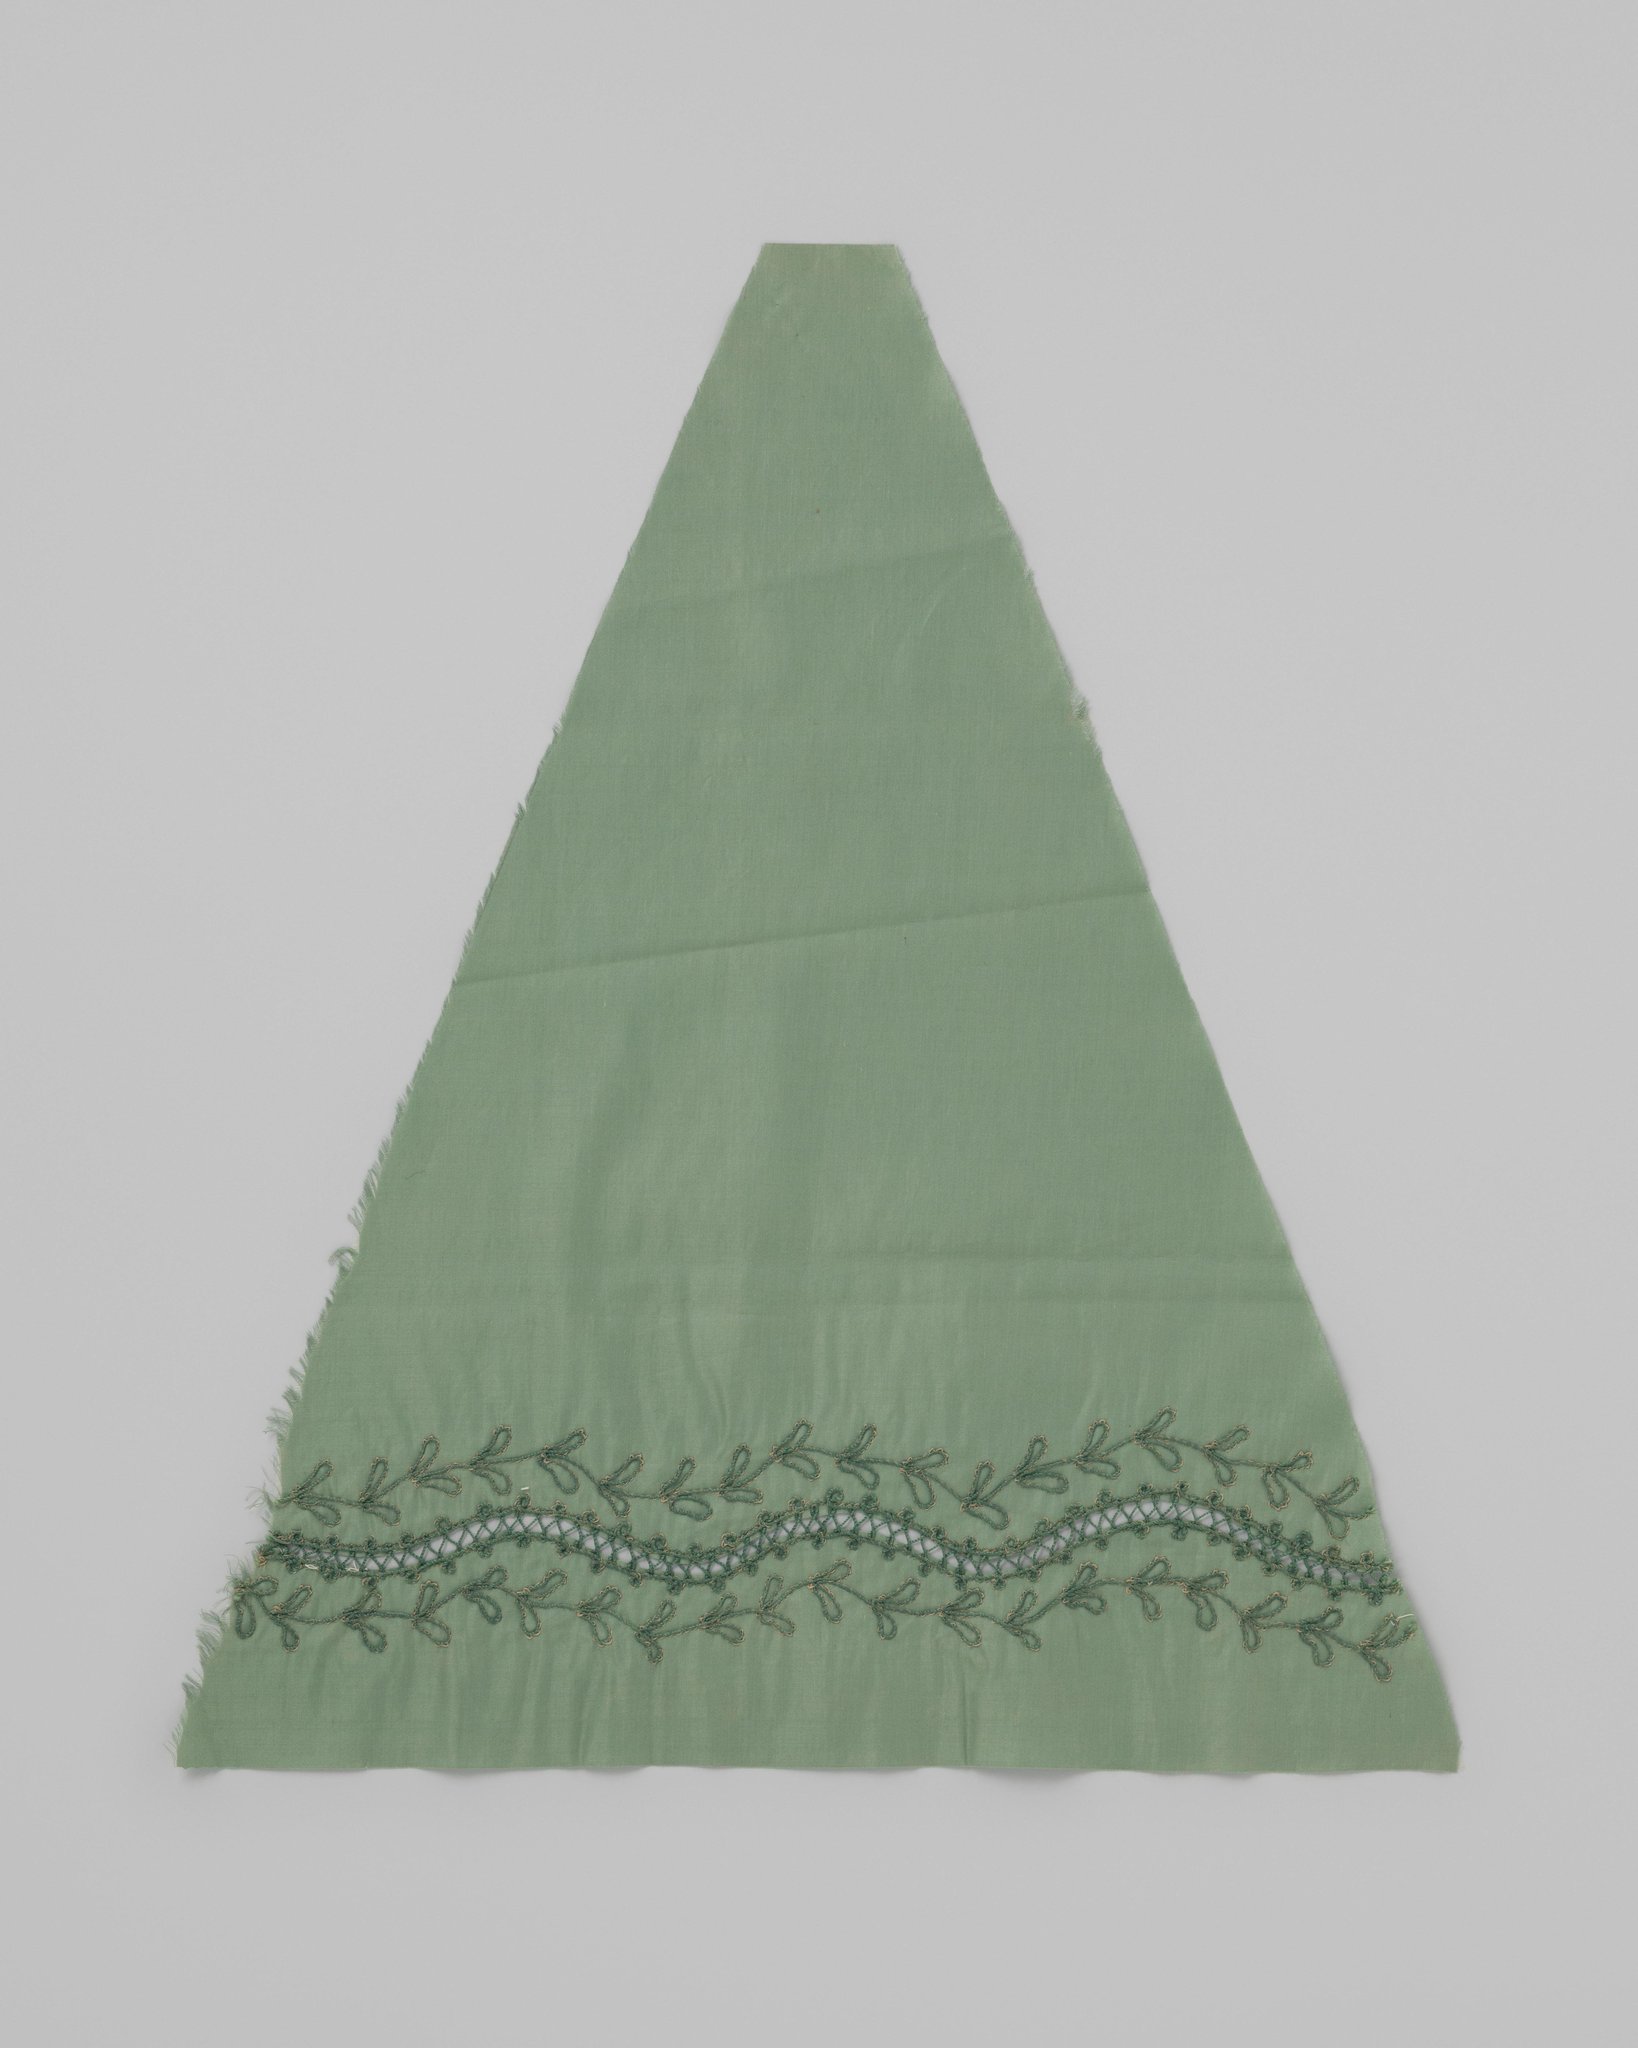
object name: parasoldek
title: Sector van een parasoldek van lichtgroene katoen, met twee geborduurde golvende bladranken waartussen een golvende opengewerkte strook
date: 1885-1900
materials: cotton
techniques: embroidered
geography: nijmegen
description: Sector van een parasoldek van lichtgroene katoen, met twee geborduurde golvende bladranken waartussen een golvende opengewerkte strook.